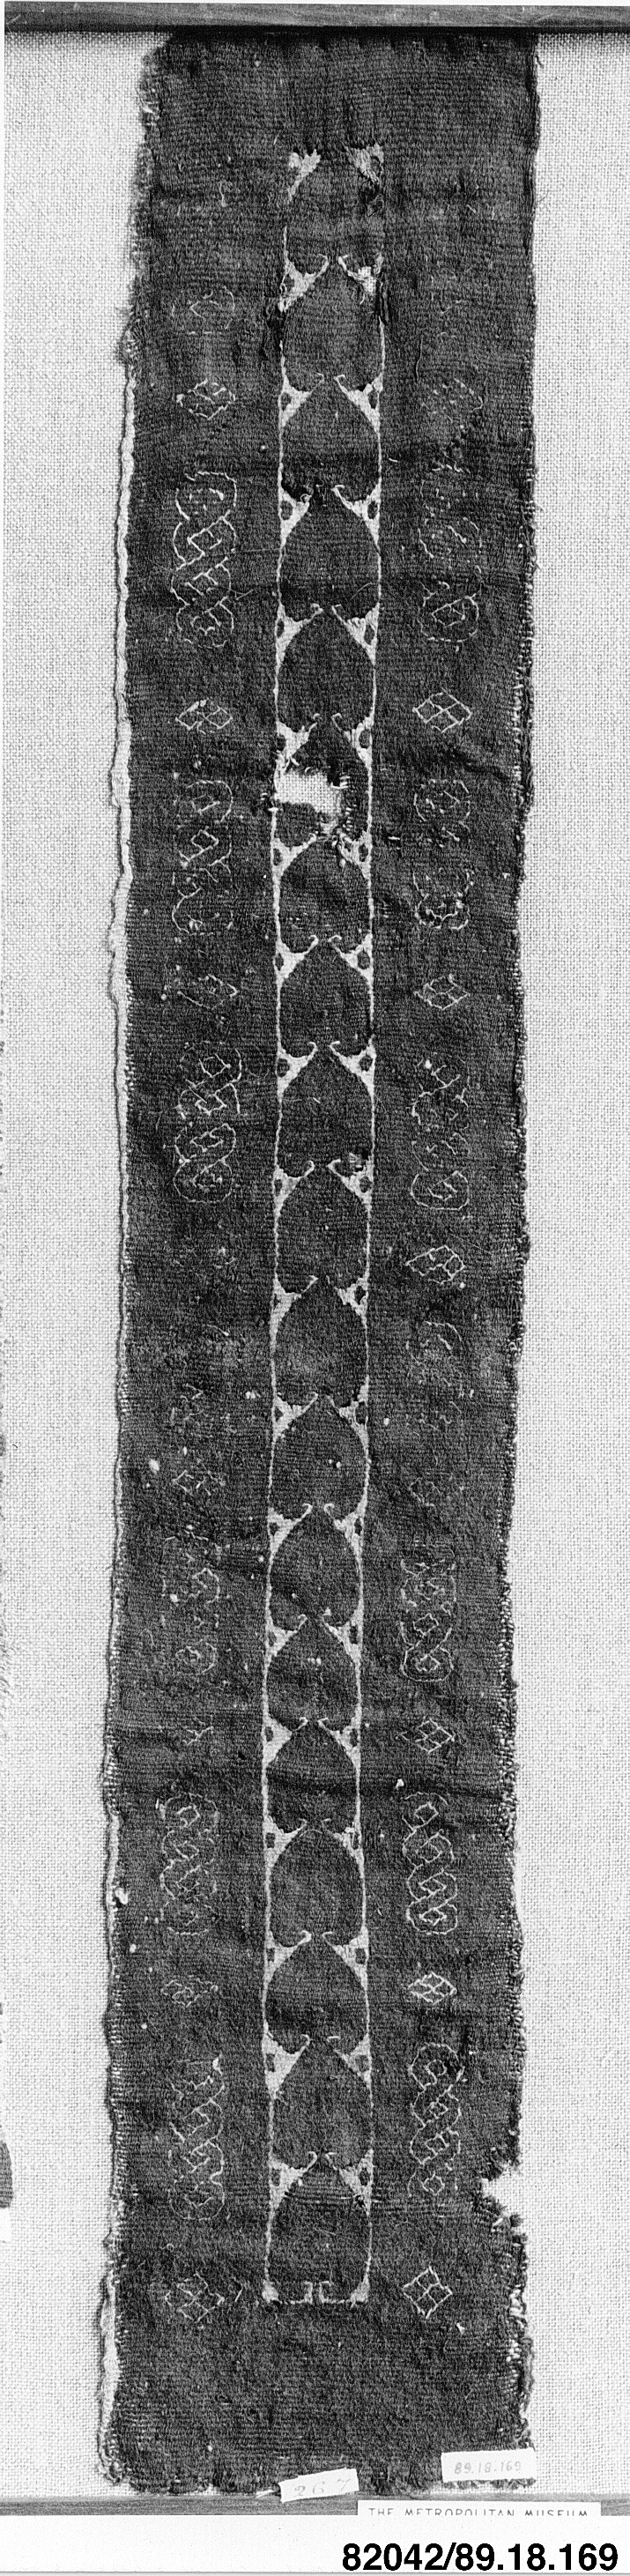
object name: textile fragment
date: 201-400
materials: linen, wool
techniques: weave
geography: egypt